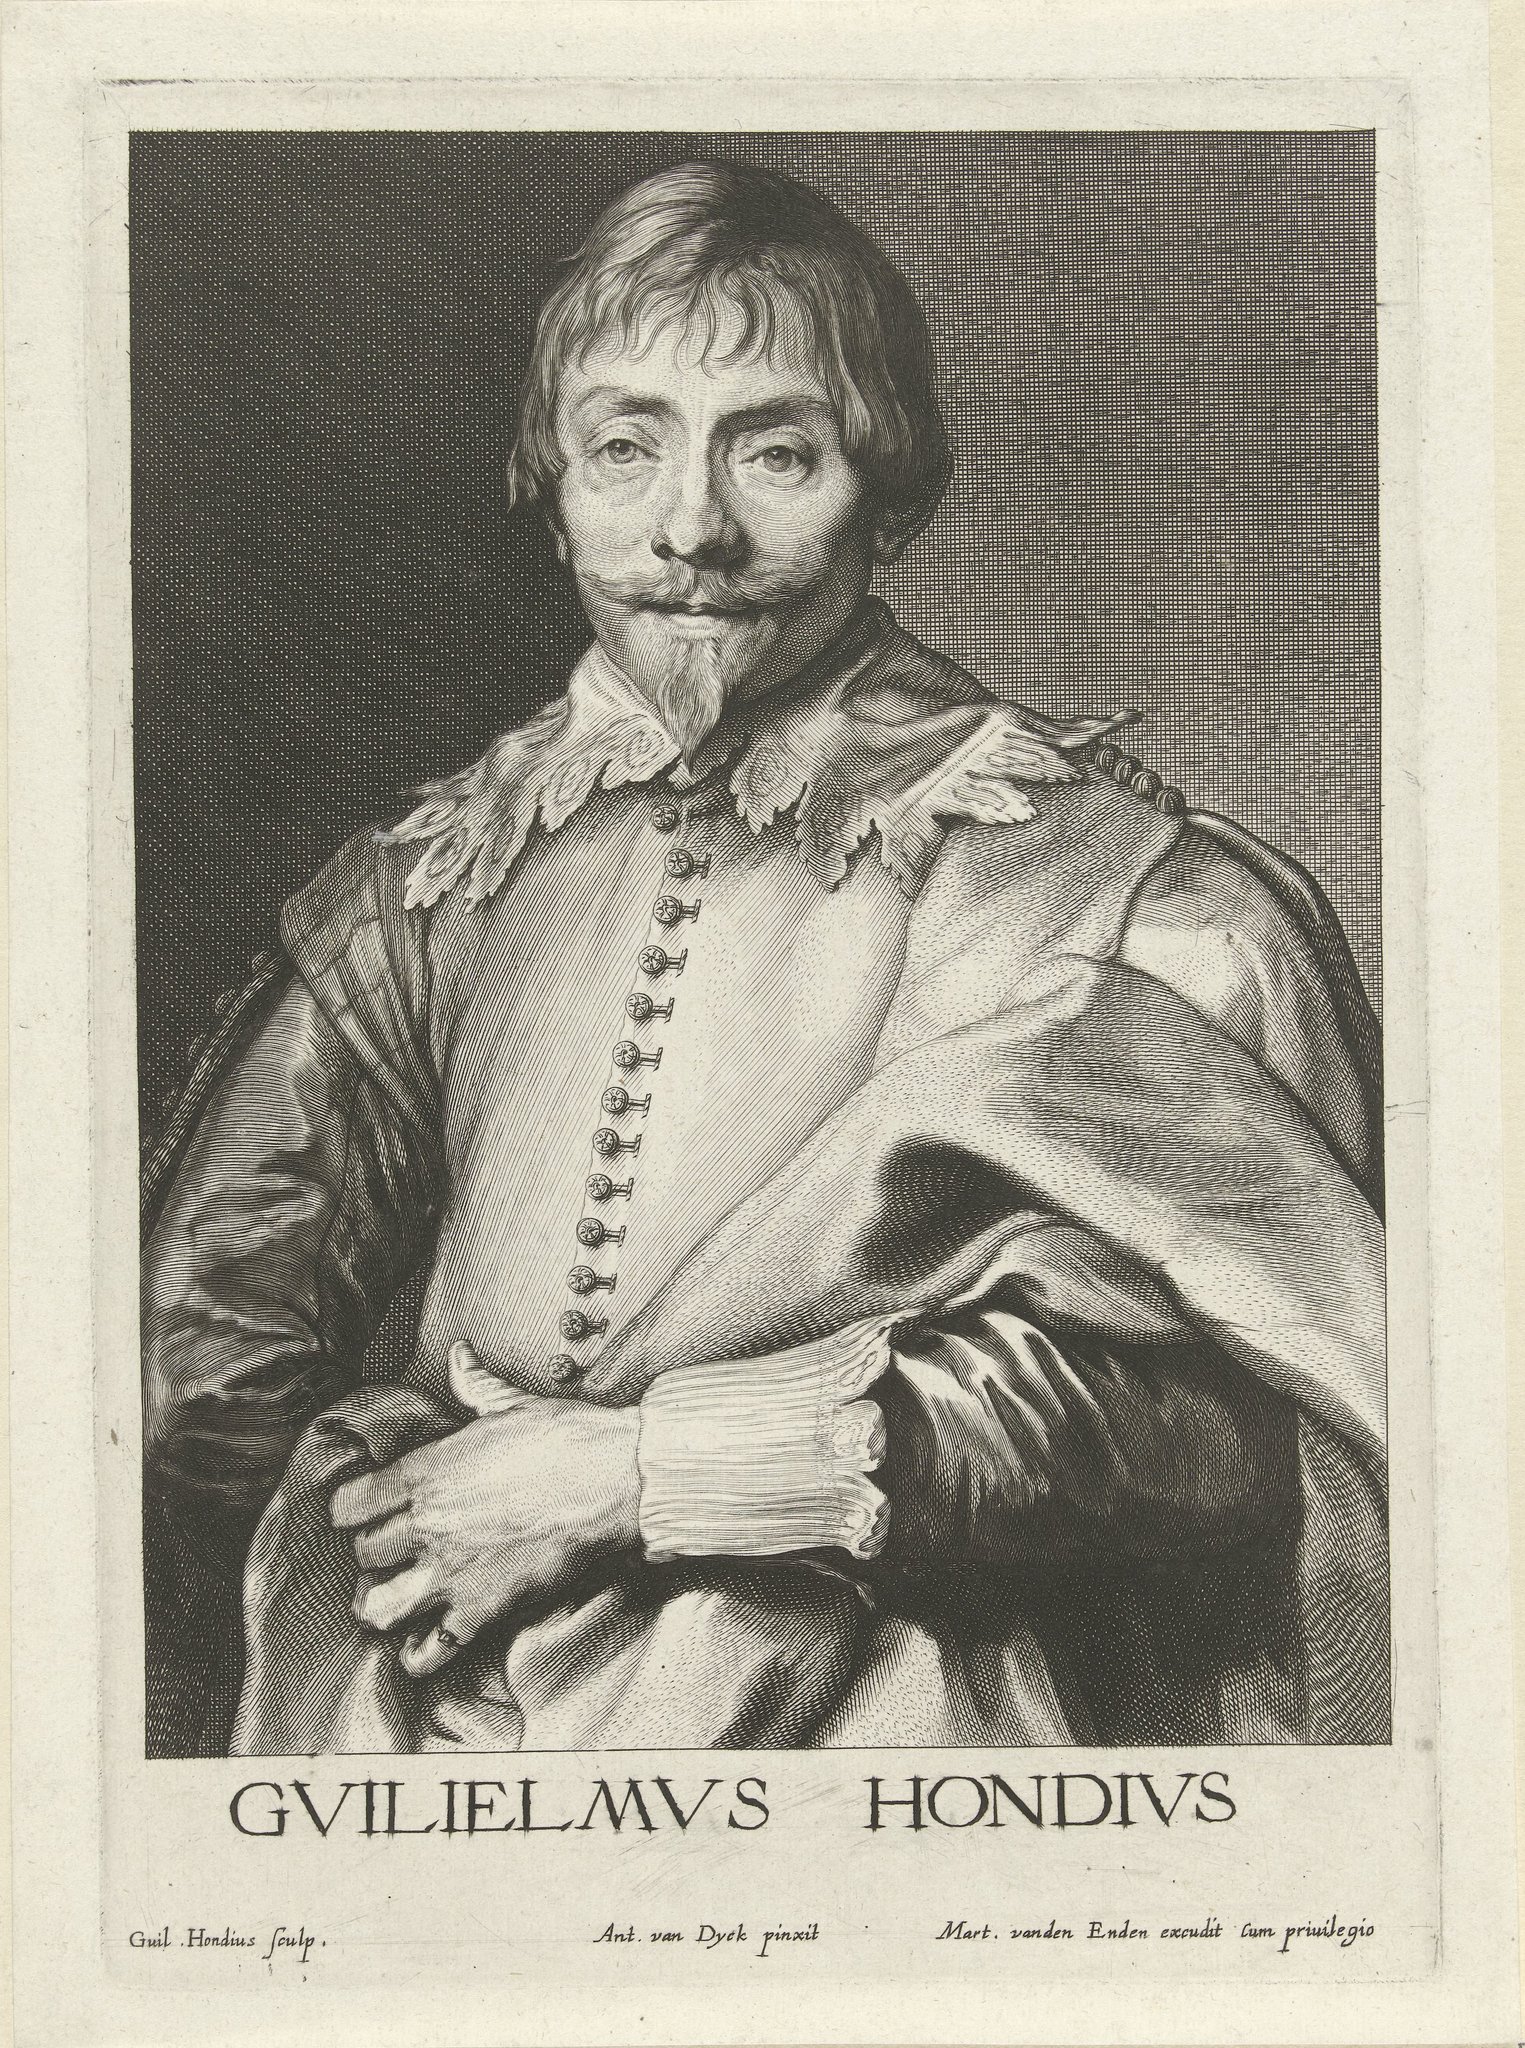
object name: print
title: Portret van Willem Hondius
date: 1630-1654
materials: paper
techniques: engraving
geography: antwerp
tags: the hague, print maker, willem hondius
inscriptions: collector's mark: Lugt 240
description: Portret ten halven lijve van Willem Hondius.